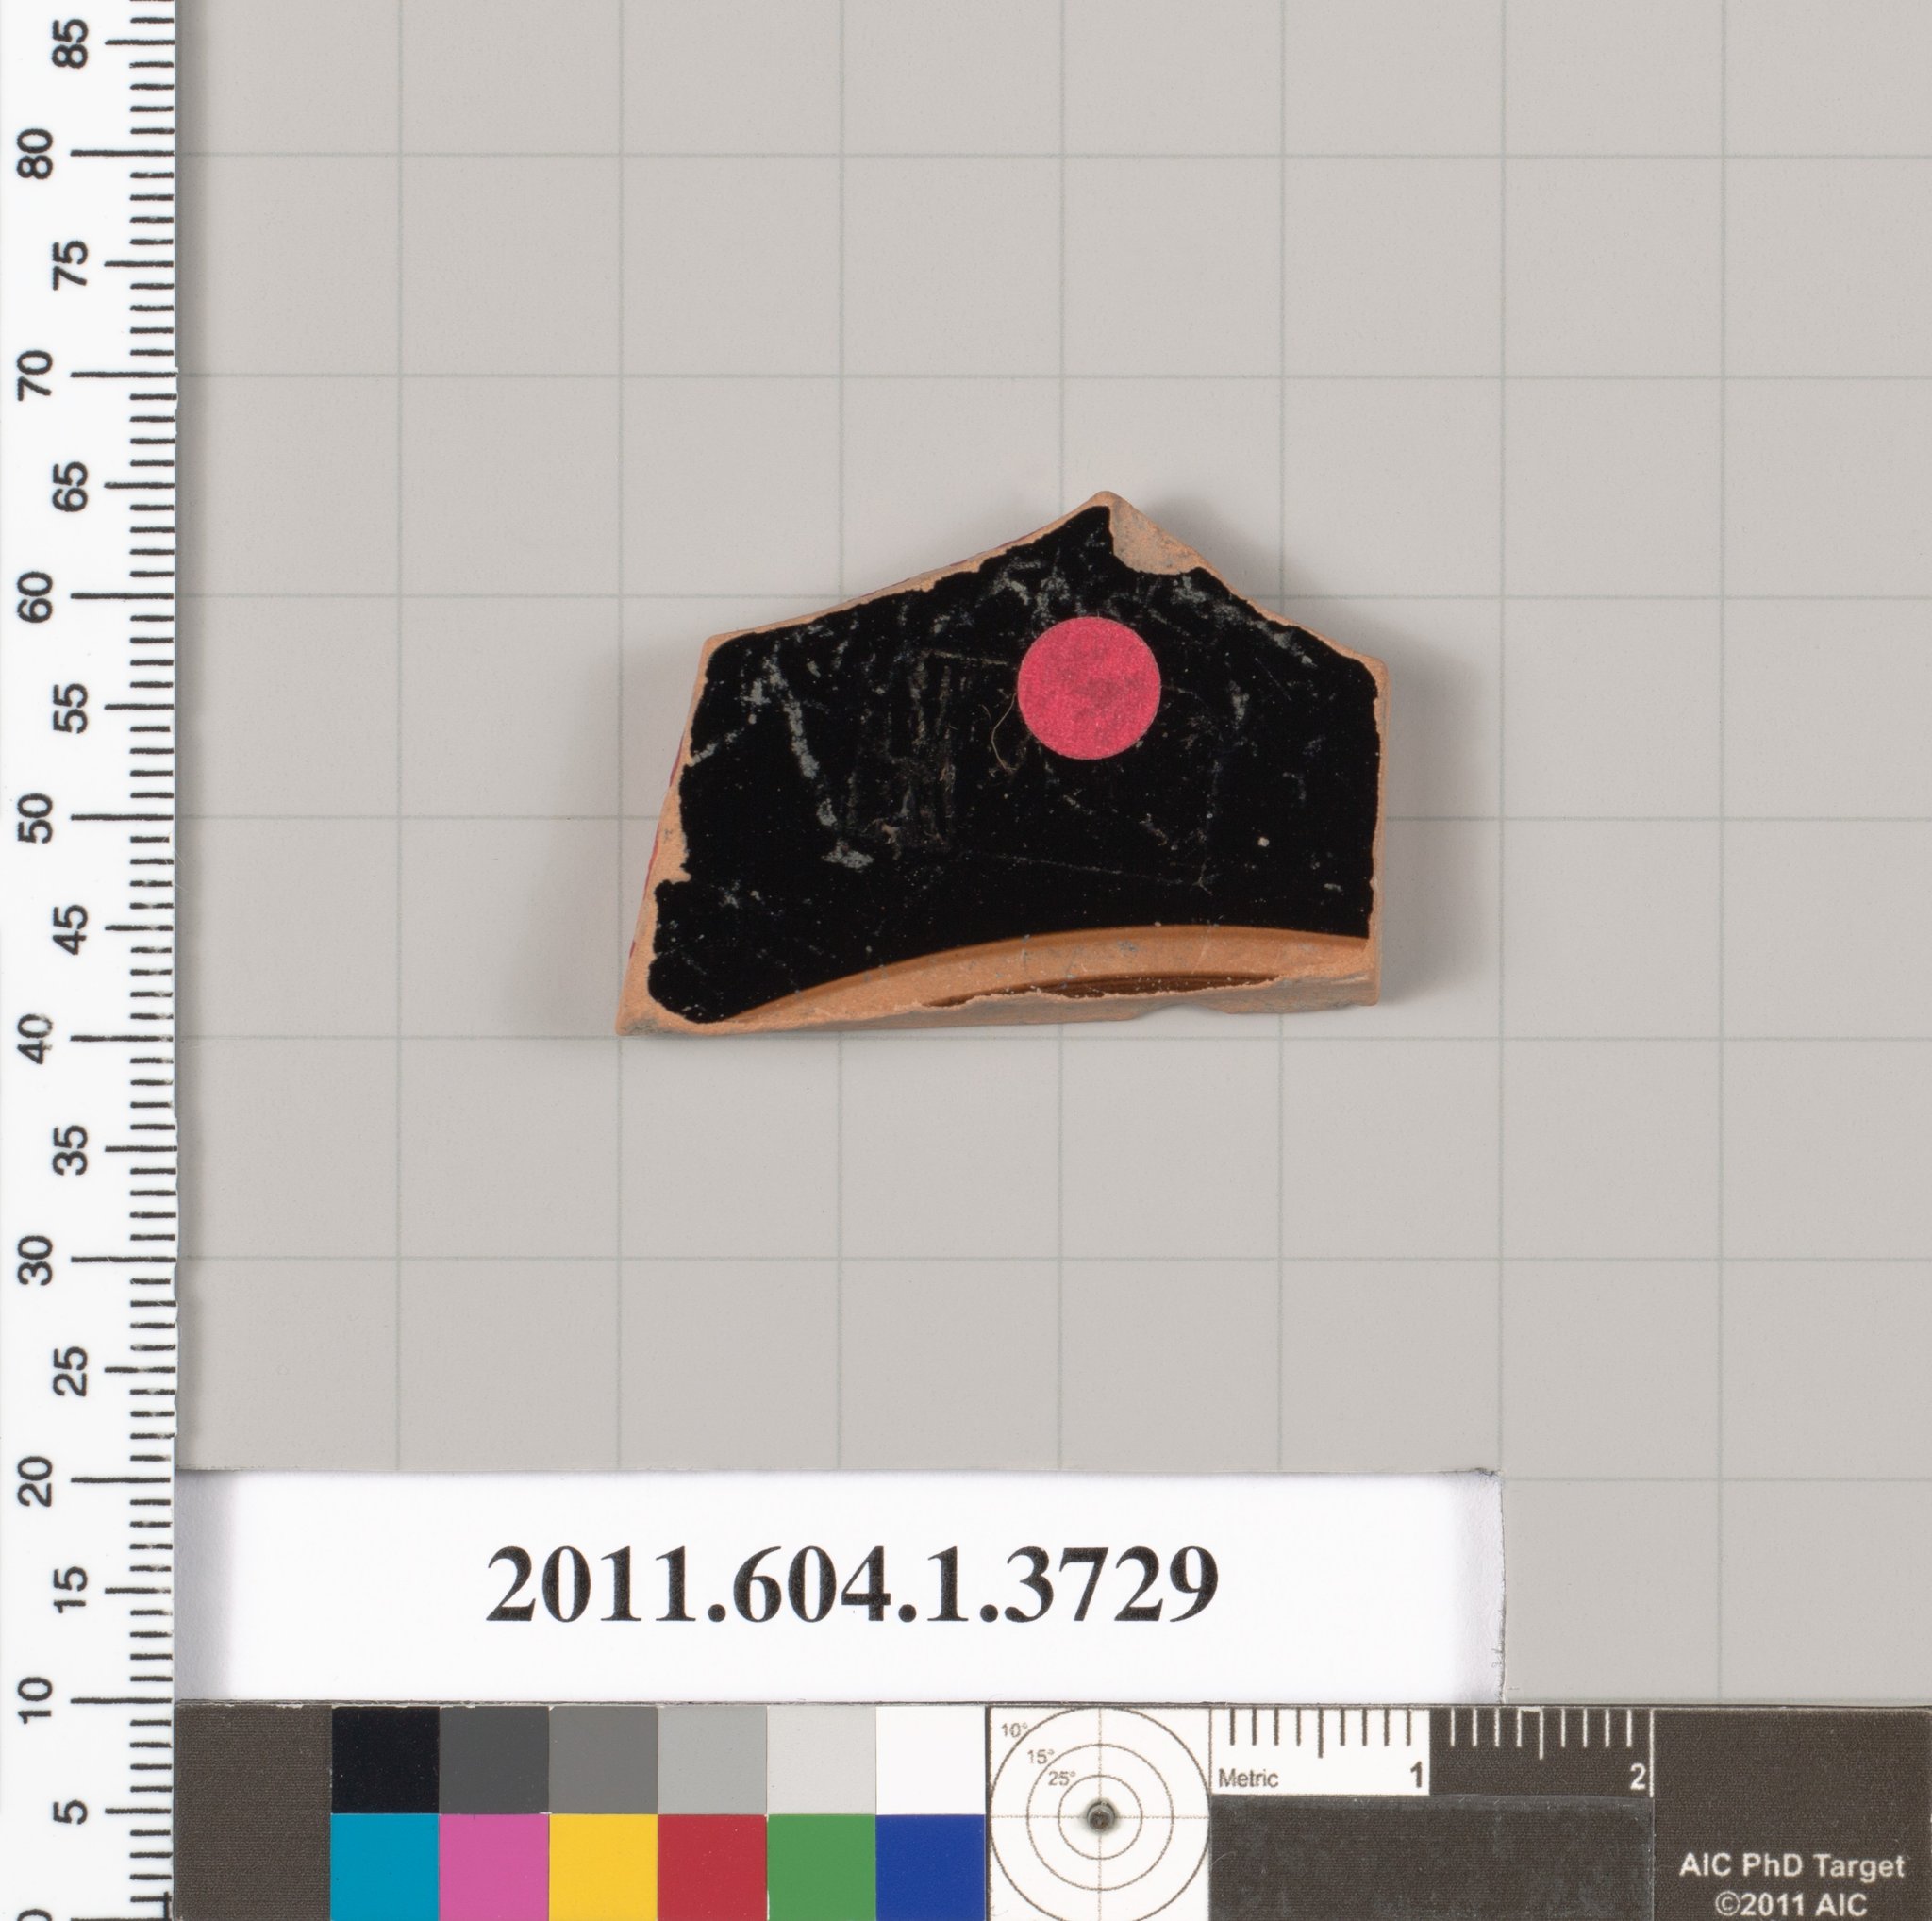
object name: kylix fragment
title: Terracotta fragment of a kylix (drinking cup)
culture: greek, attic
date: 475-451 BCE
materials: terracotta